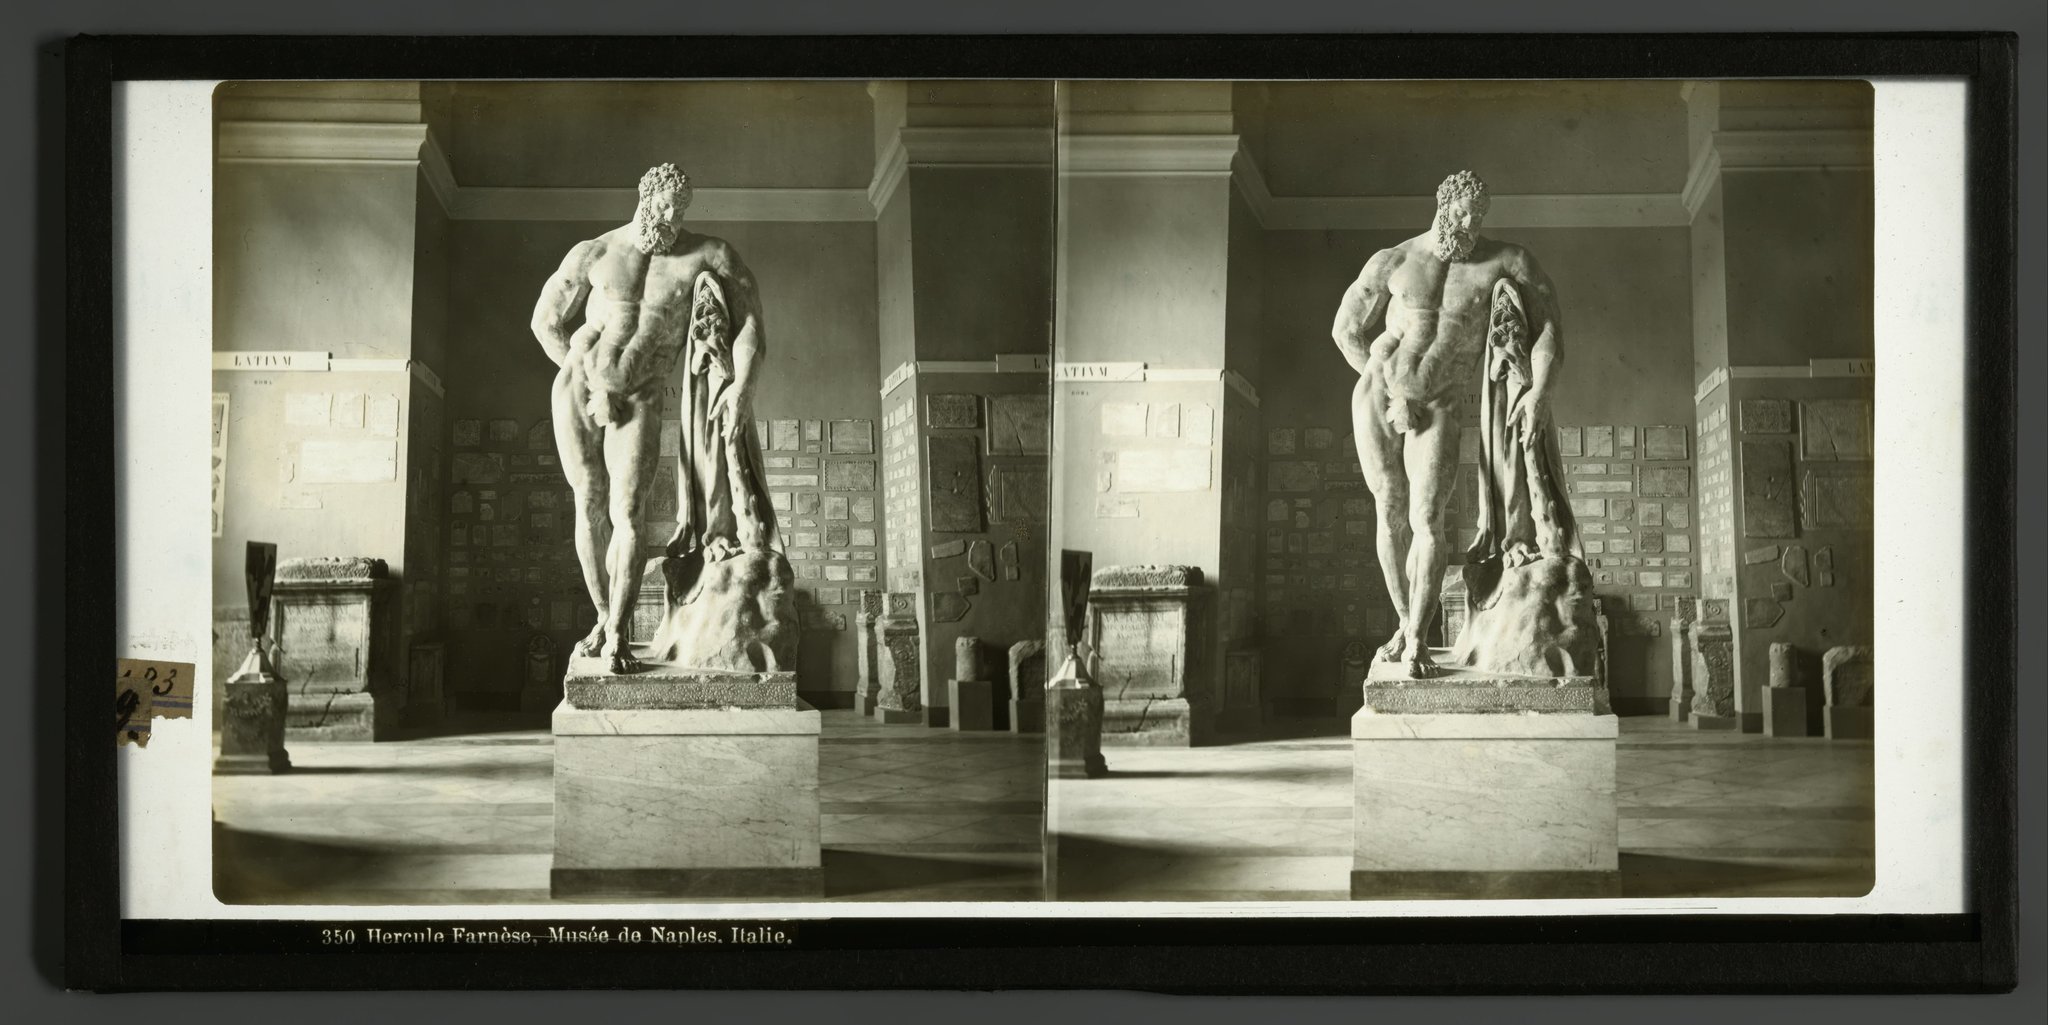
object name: stereoscopic photograph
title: Hercule Farnèse, Musée de Naples, Italie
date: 1860-1870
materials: glass, paper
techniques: slide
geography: naples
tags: (story of) hercules (heracles), piece of sculpture, reproduction of a piece of sculpture, permanent exhibition, museum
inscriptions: number: ‘350’, number: ‘1[.]3/9.’